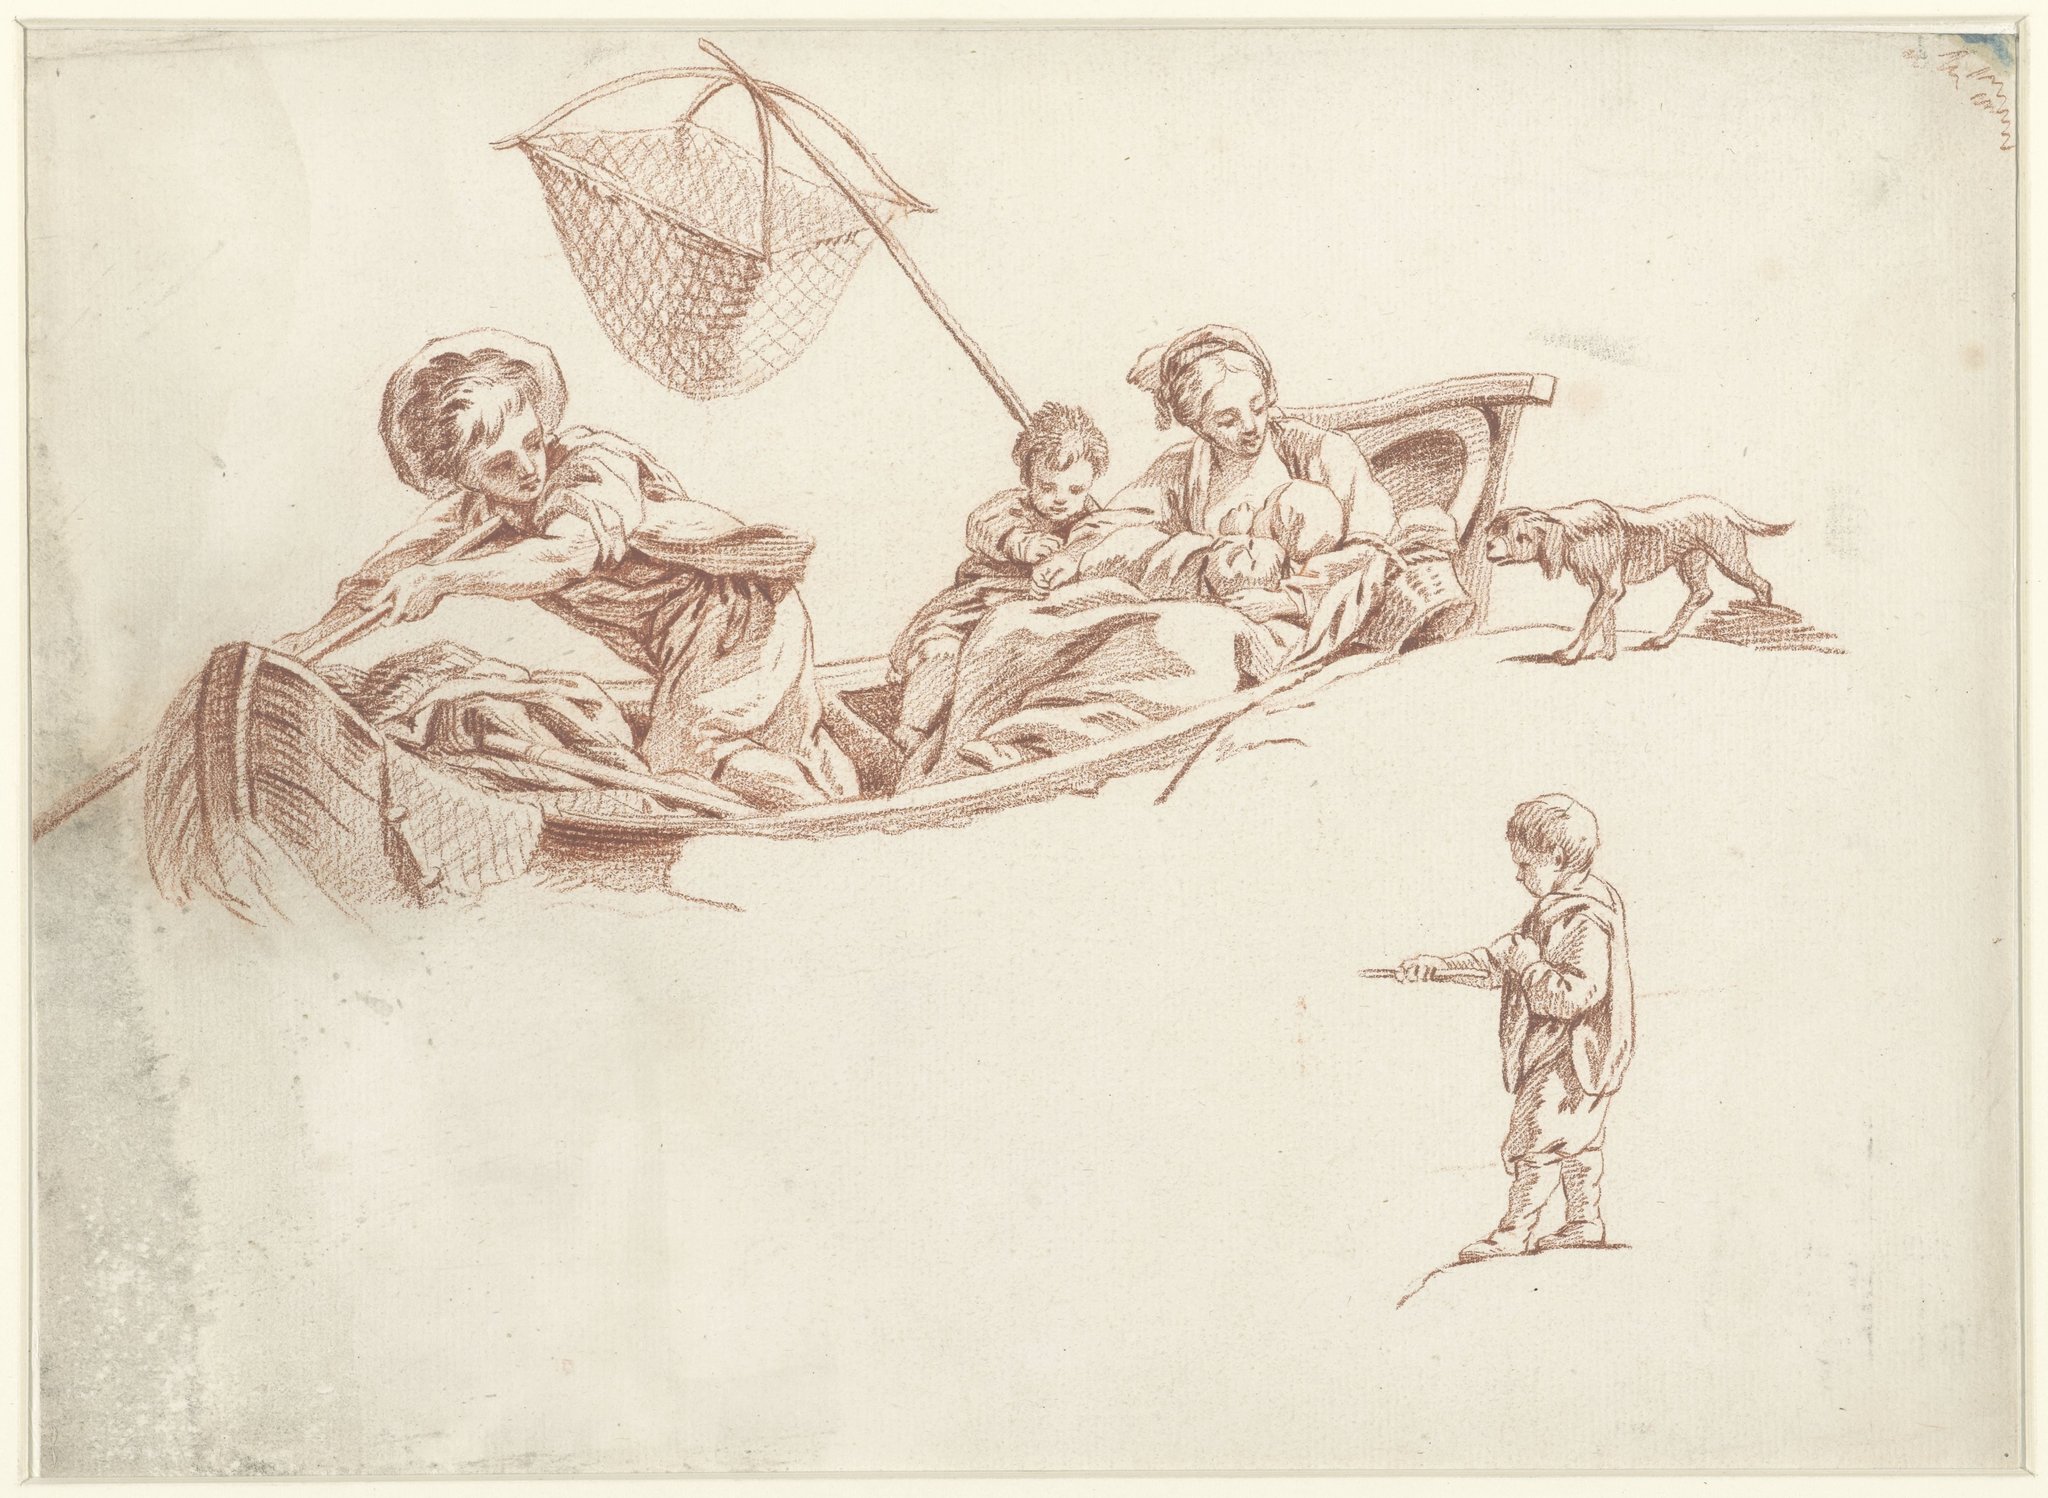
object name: drawing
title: Moeder met kinderen in een boot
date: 1735-1800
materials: chalk, paper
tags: mother and baby or young child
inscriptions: collector's mark, verso, lower centre: Lugt 2228